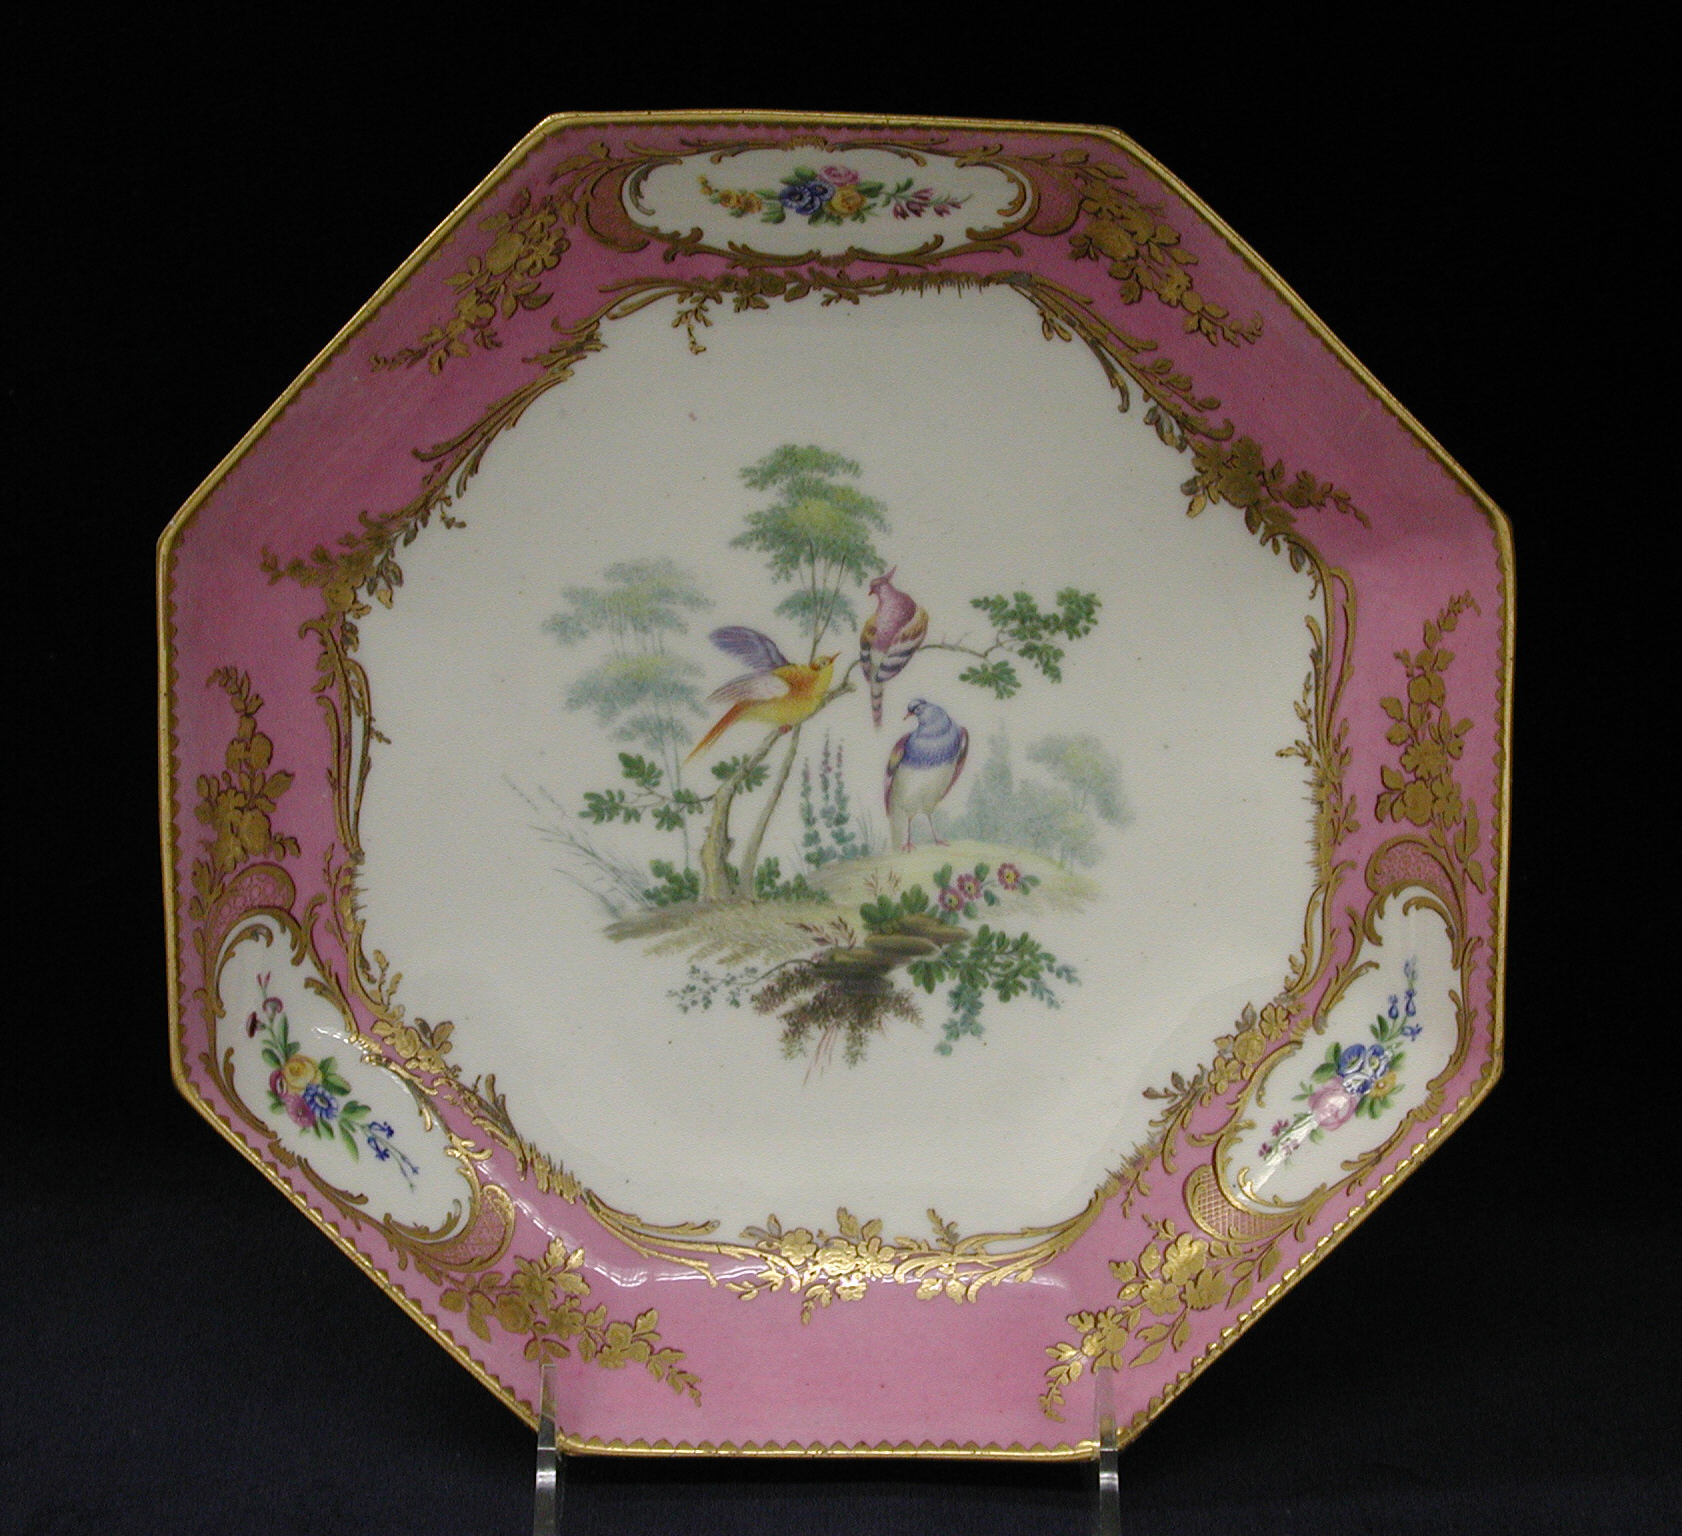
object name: dish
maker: sèvres manufactory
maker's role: manufactory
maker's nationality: french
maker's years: 1740-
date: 1701-1900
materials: soft paste porcelain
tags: birds,trees